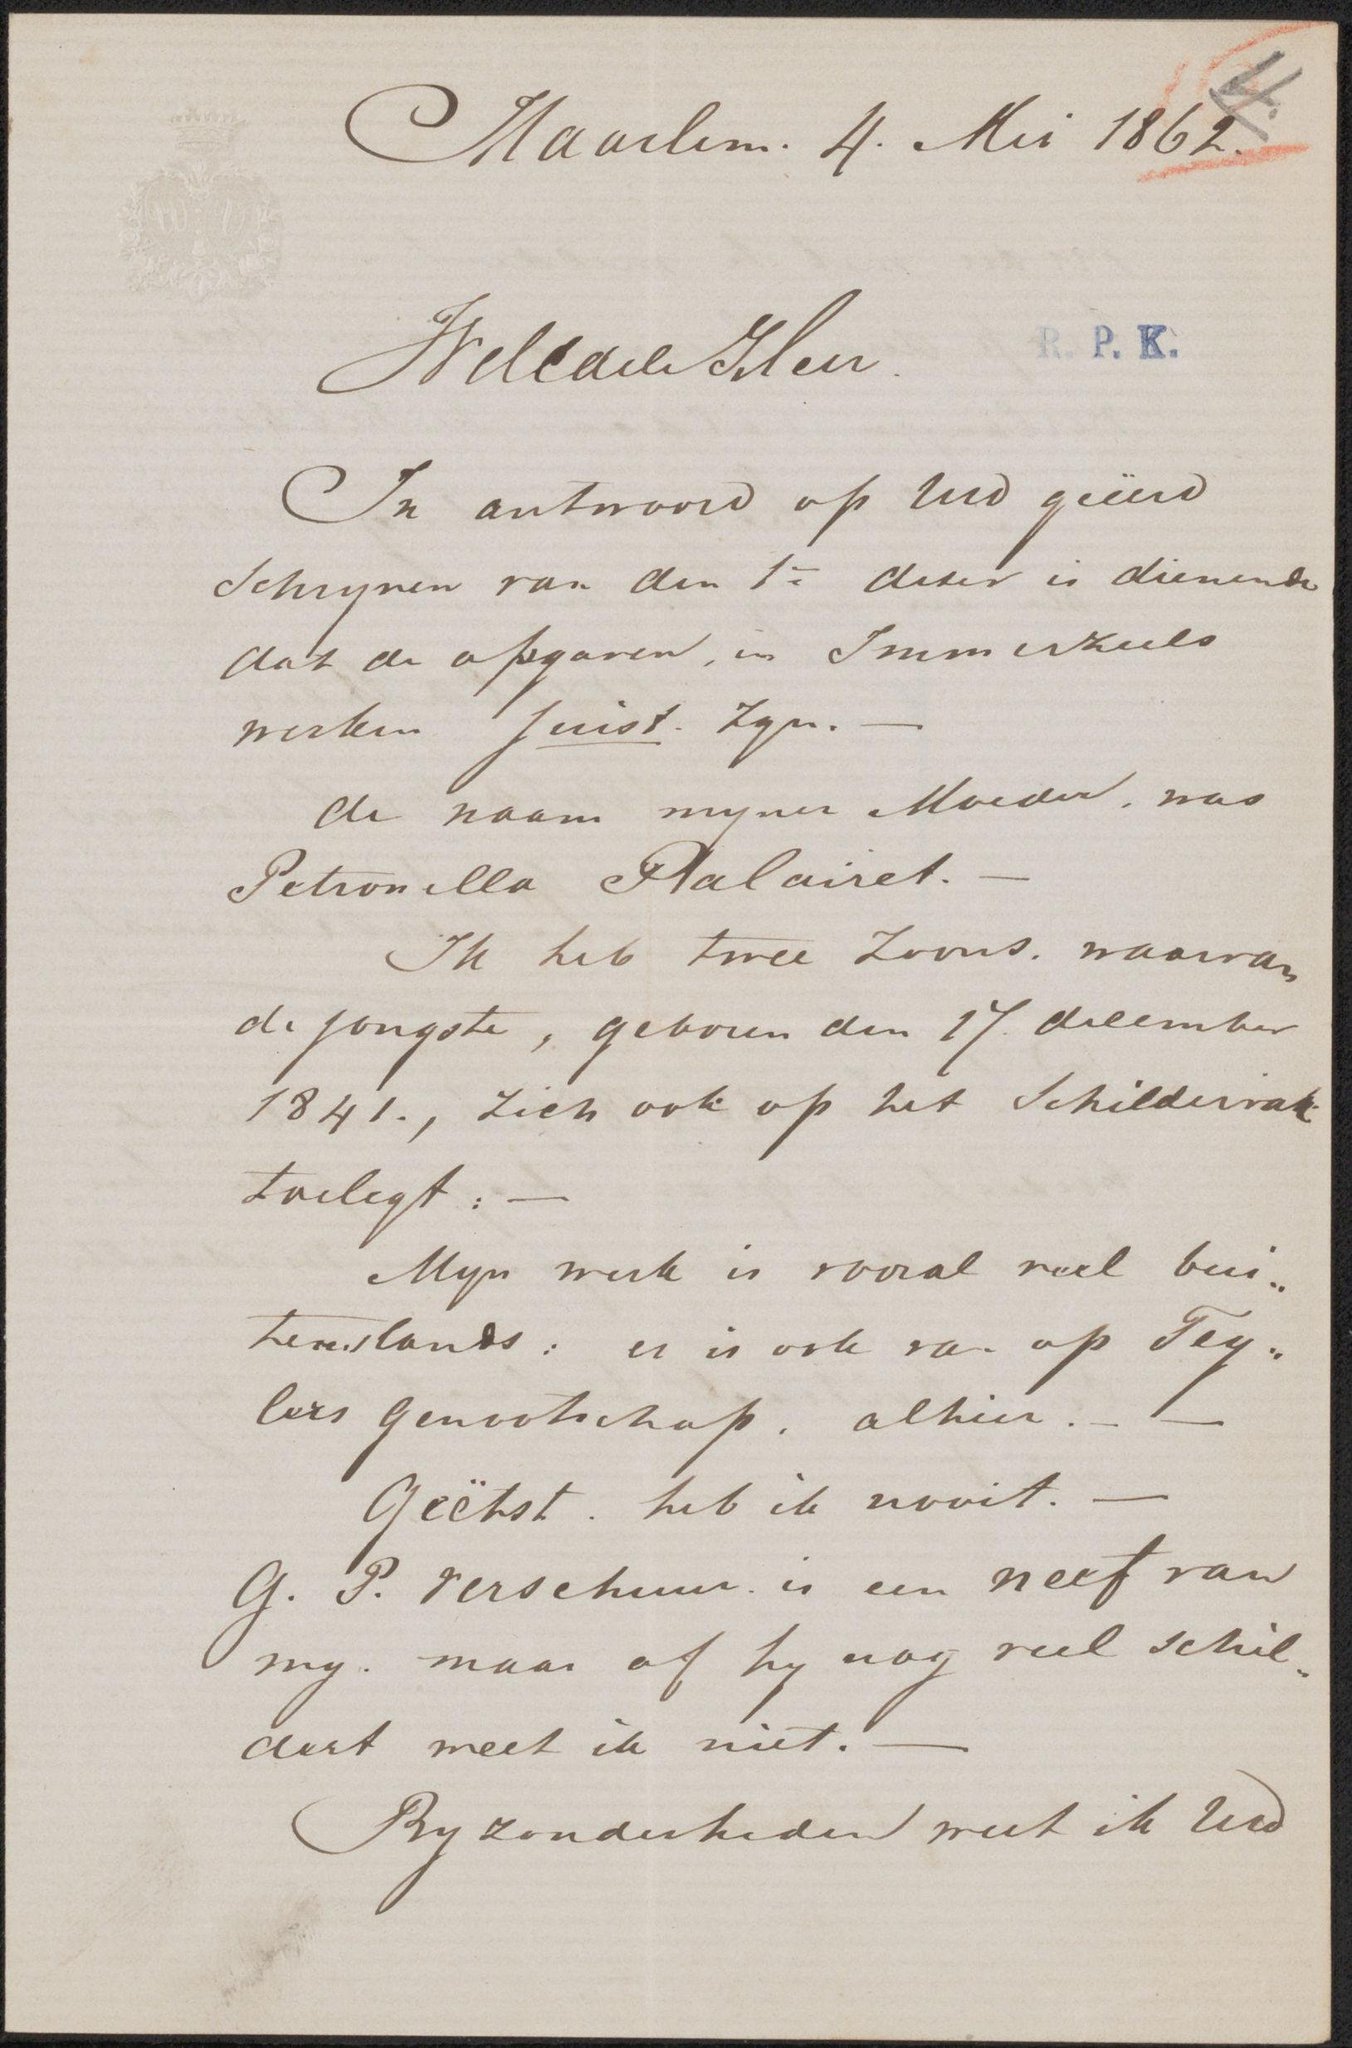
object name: letter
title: Brief aan Christiaan Kramm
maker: wouter verschuur (1812-1874)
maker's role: draughtsman, painter, print maker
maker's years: 1812-1874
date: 1862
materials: ink, paper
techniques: pen, writing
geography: haarlem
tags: gerrit pieter verschuur, wouter verschuur (1841-1936), utrecht, christiaan kramm, distribution of awards ~ art contest, the graphic arts, painting (including book-illumination, miniature-painting), exhibition ~ art, historical persons (portraits and scenes from the life), the hague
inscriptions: collector's mark: Lugt 2233, monogram